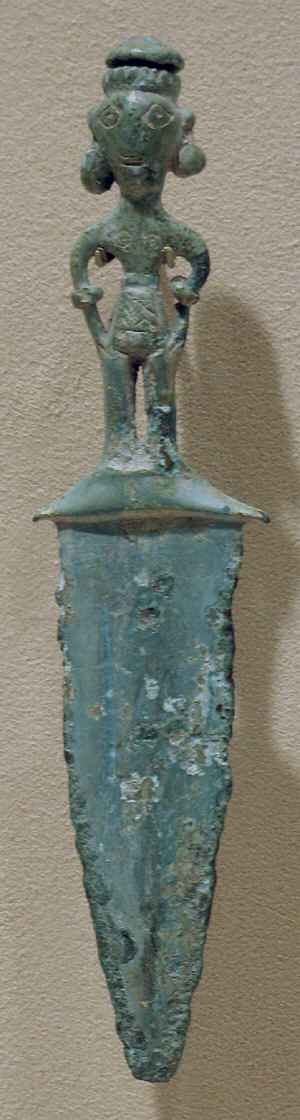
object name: dagger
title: Dagger with a Handle in the Form of a Male Figure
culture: vietnamese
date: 500 BCE-300 CE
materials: bronze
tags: daggers,men